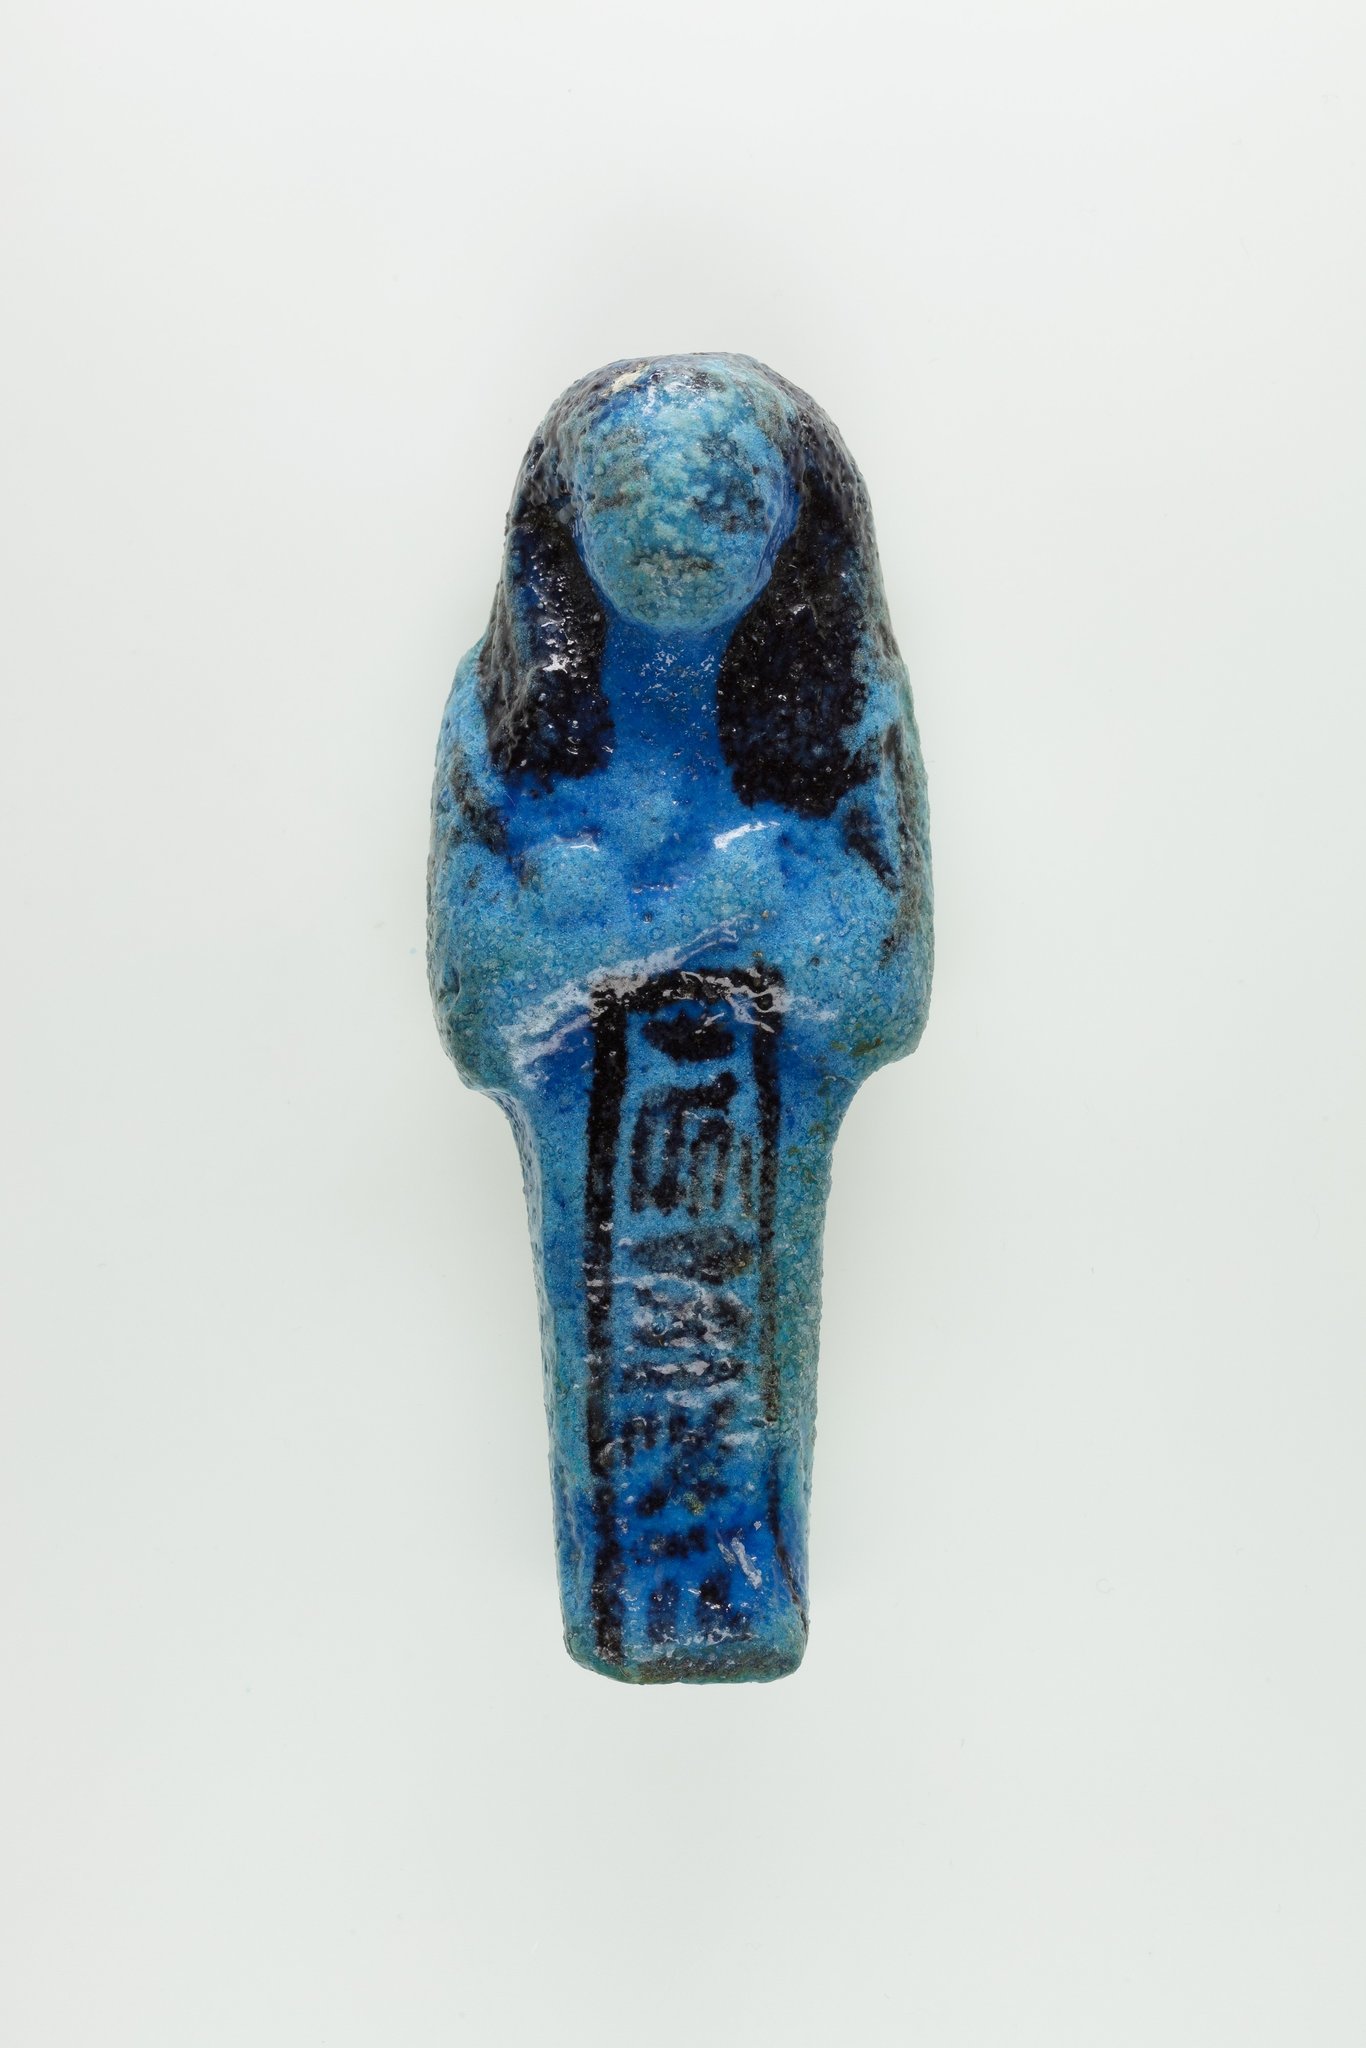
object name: shabti, worker, nauny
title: Worker Shabti of Nauny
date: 1050 BCE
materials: faience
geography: egypt